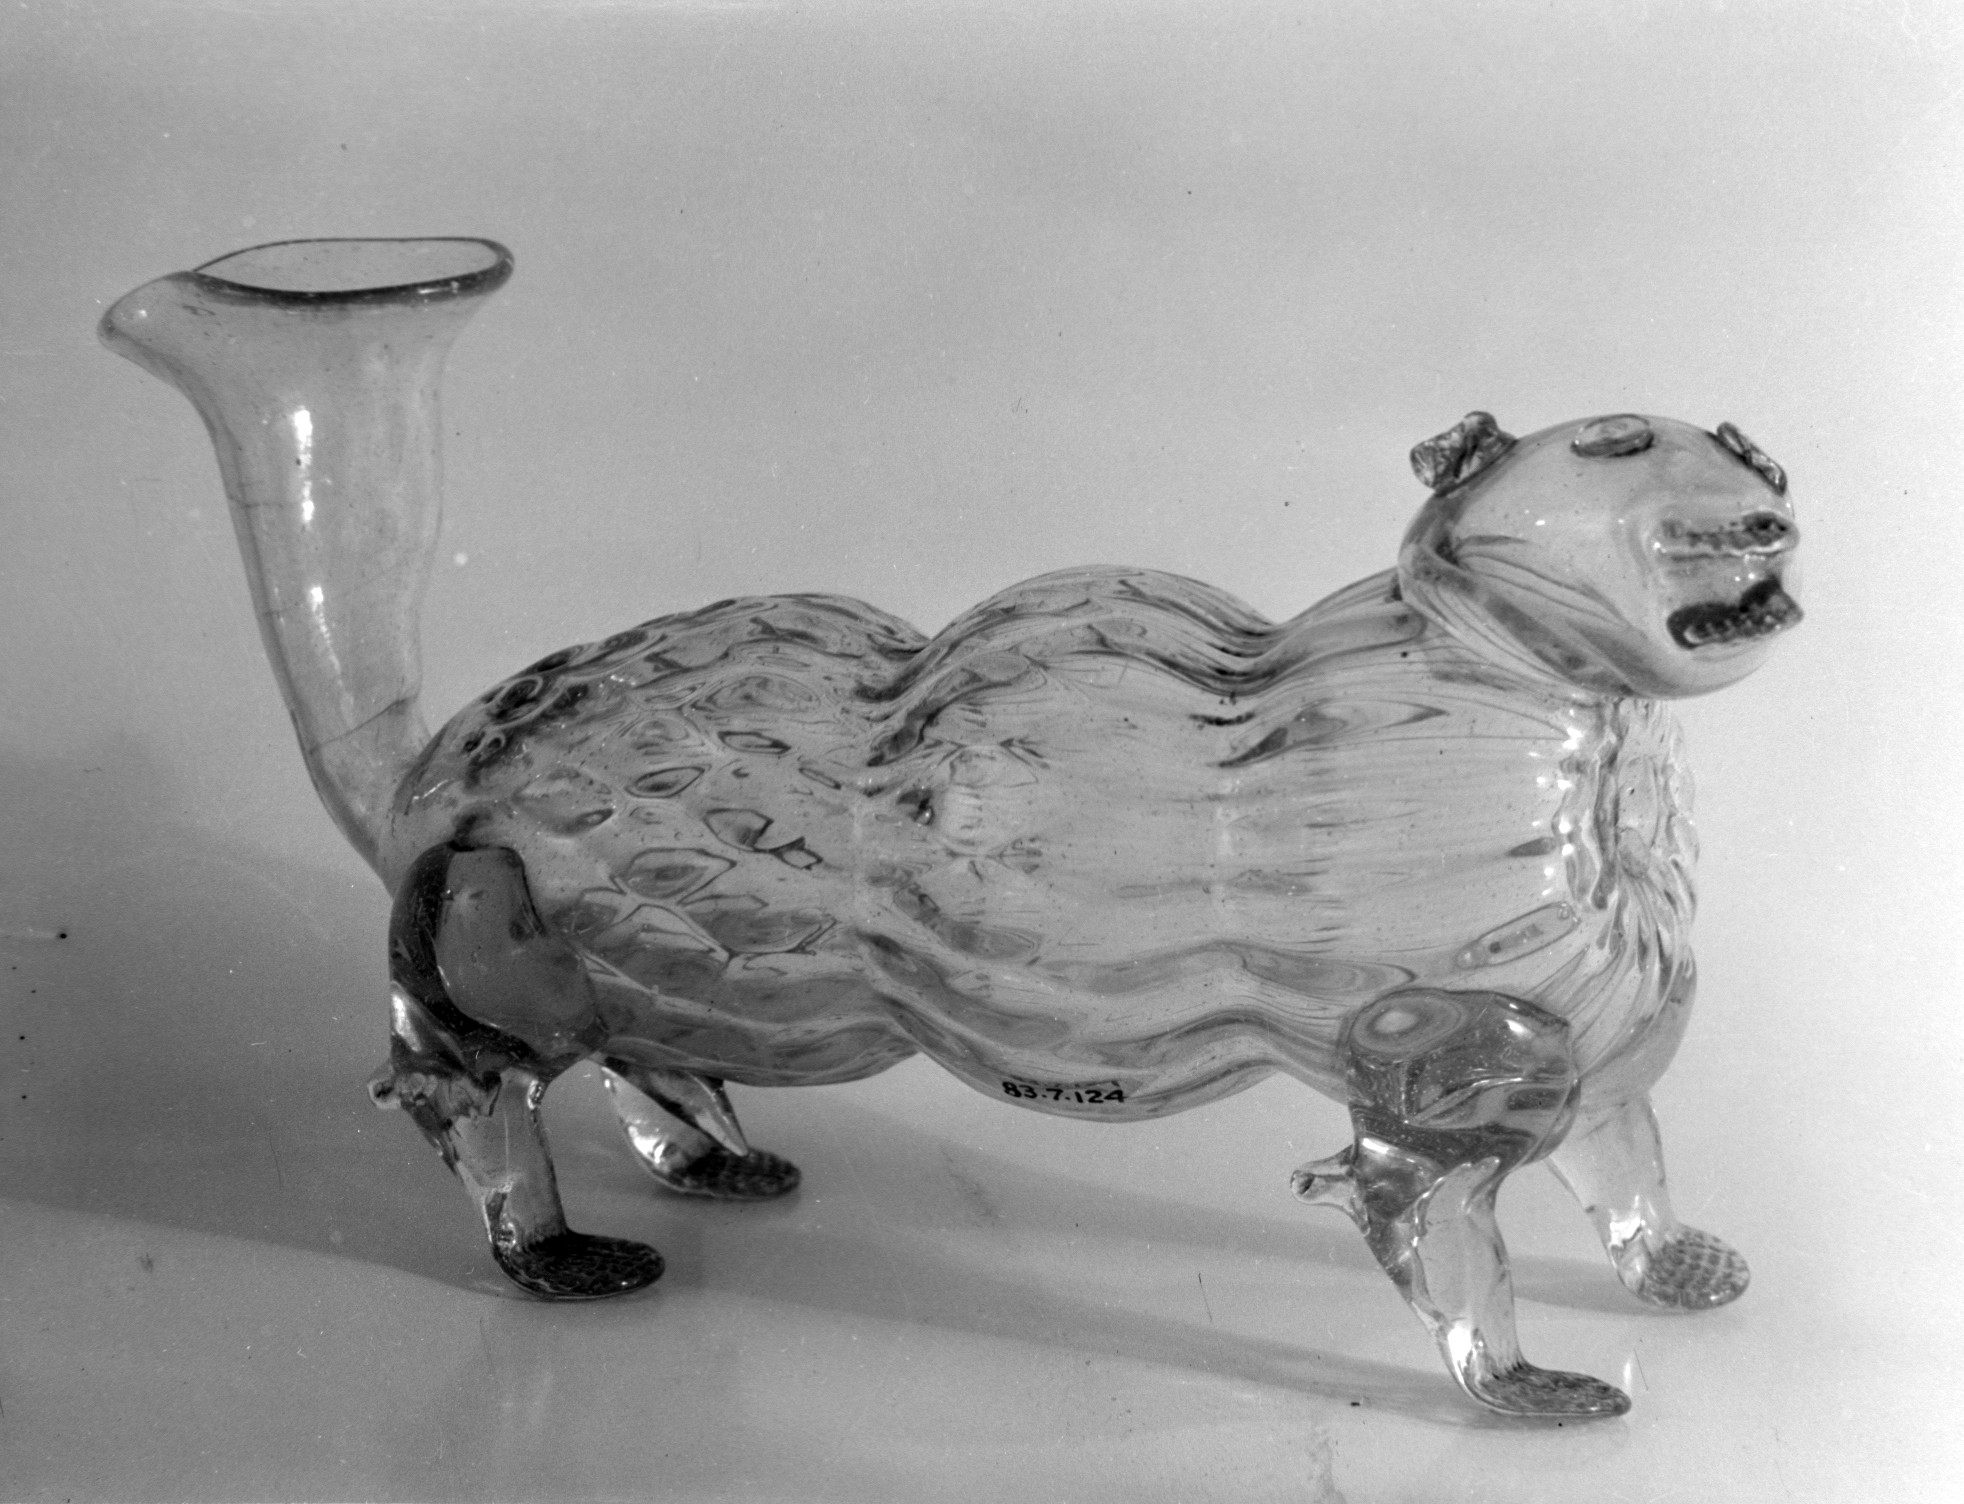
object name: oil lamp or bottle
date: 1601-1800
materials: glass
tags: animals